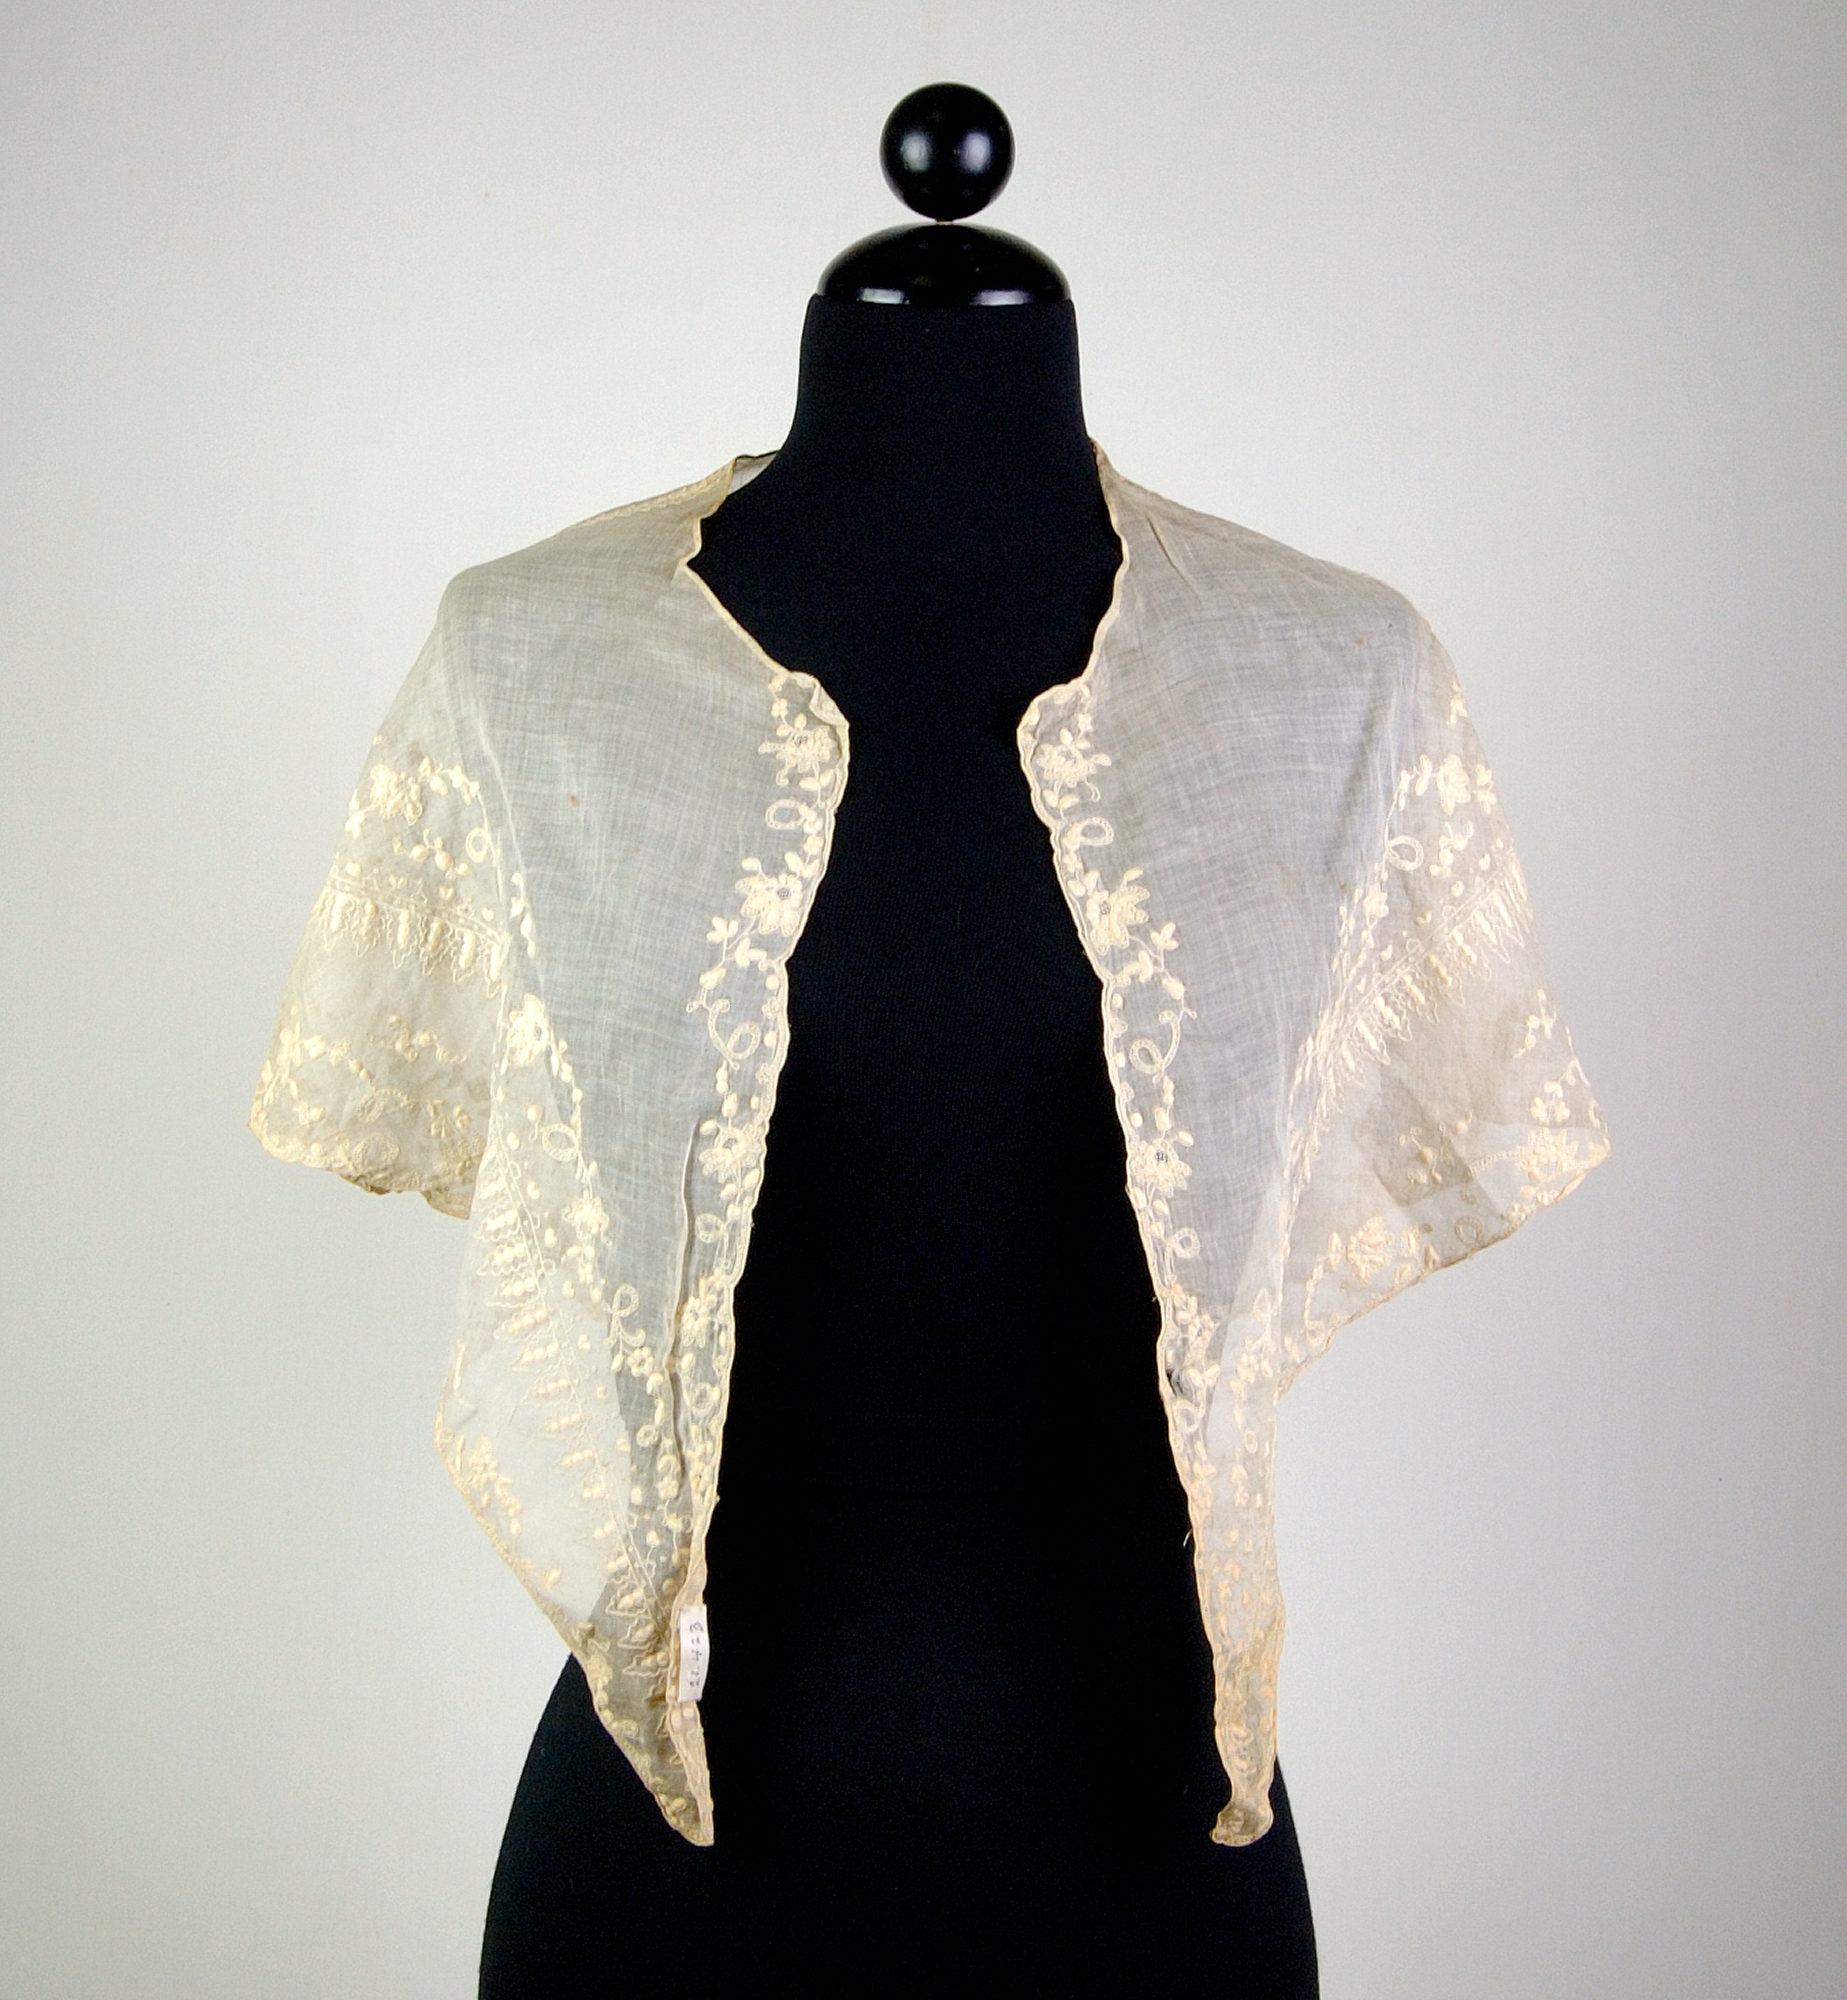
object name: pelerine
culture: french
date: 1840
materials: cotton